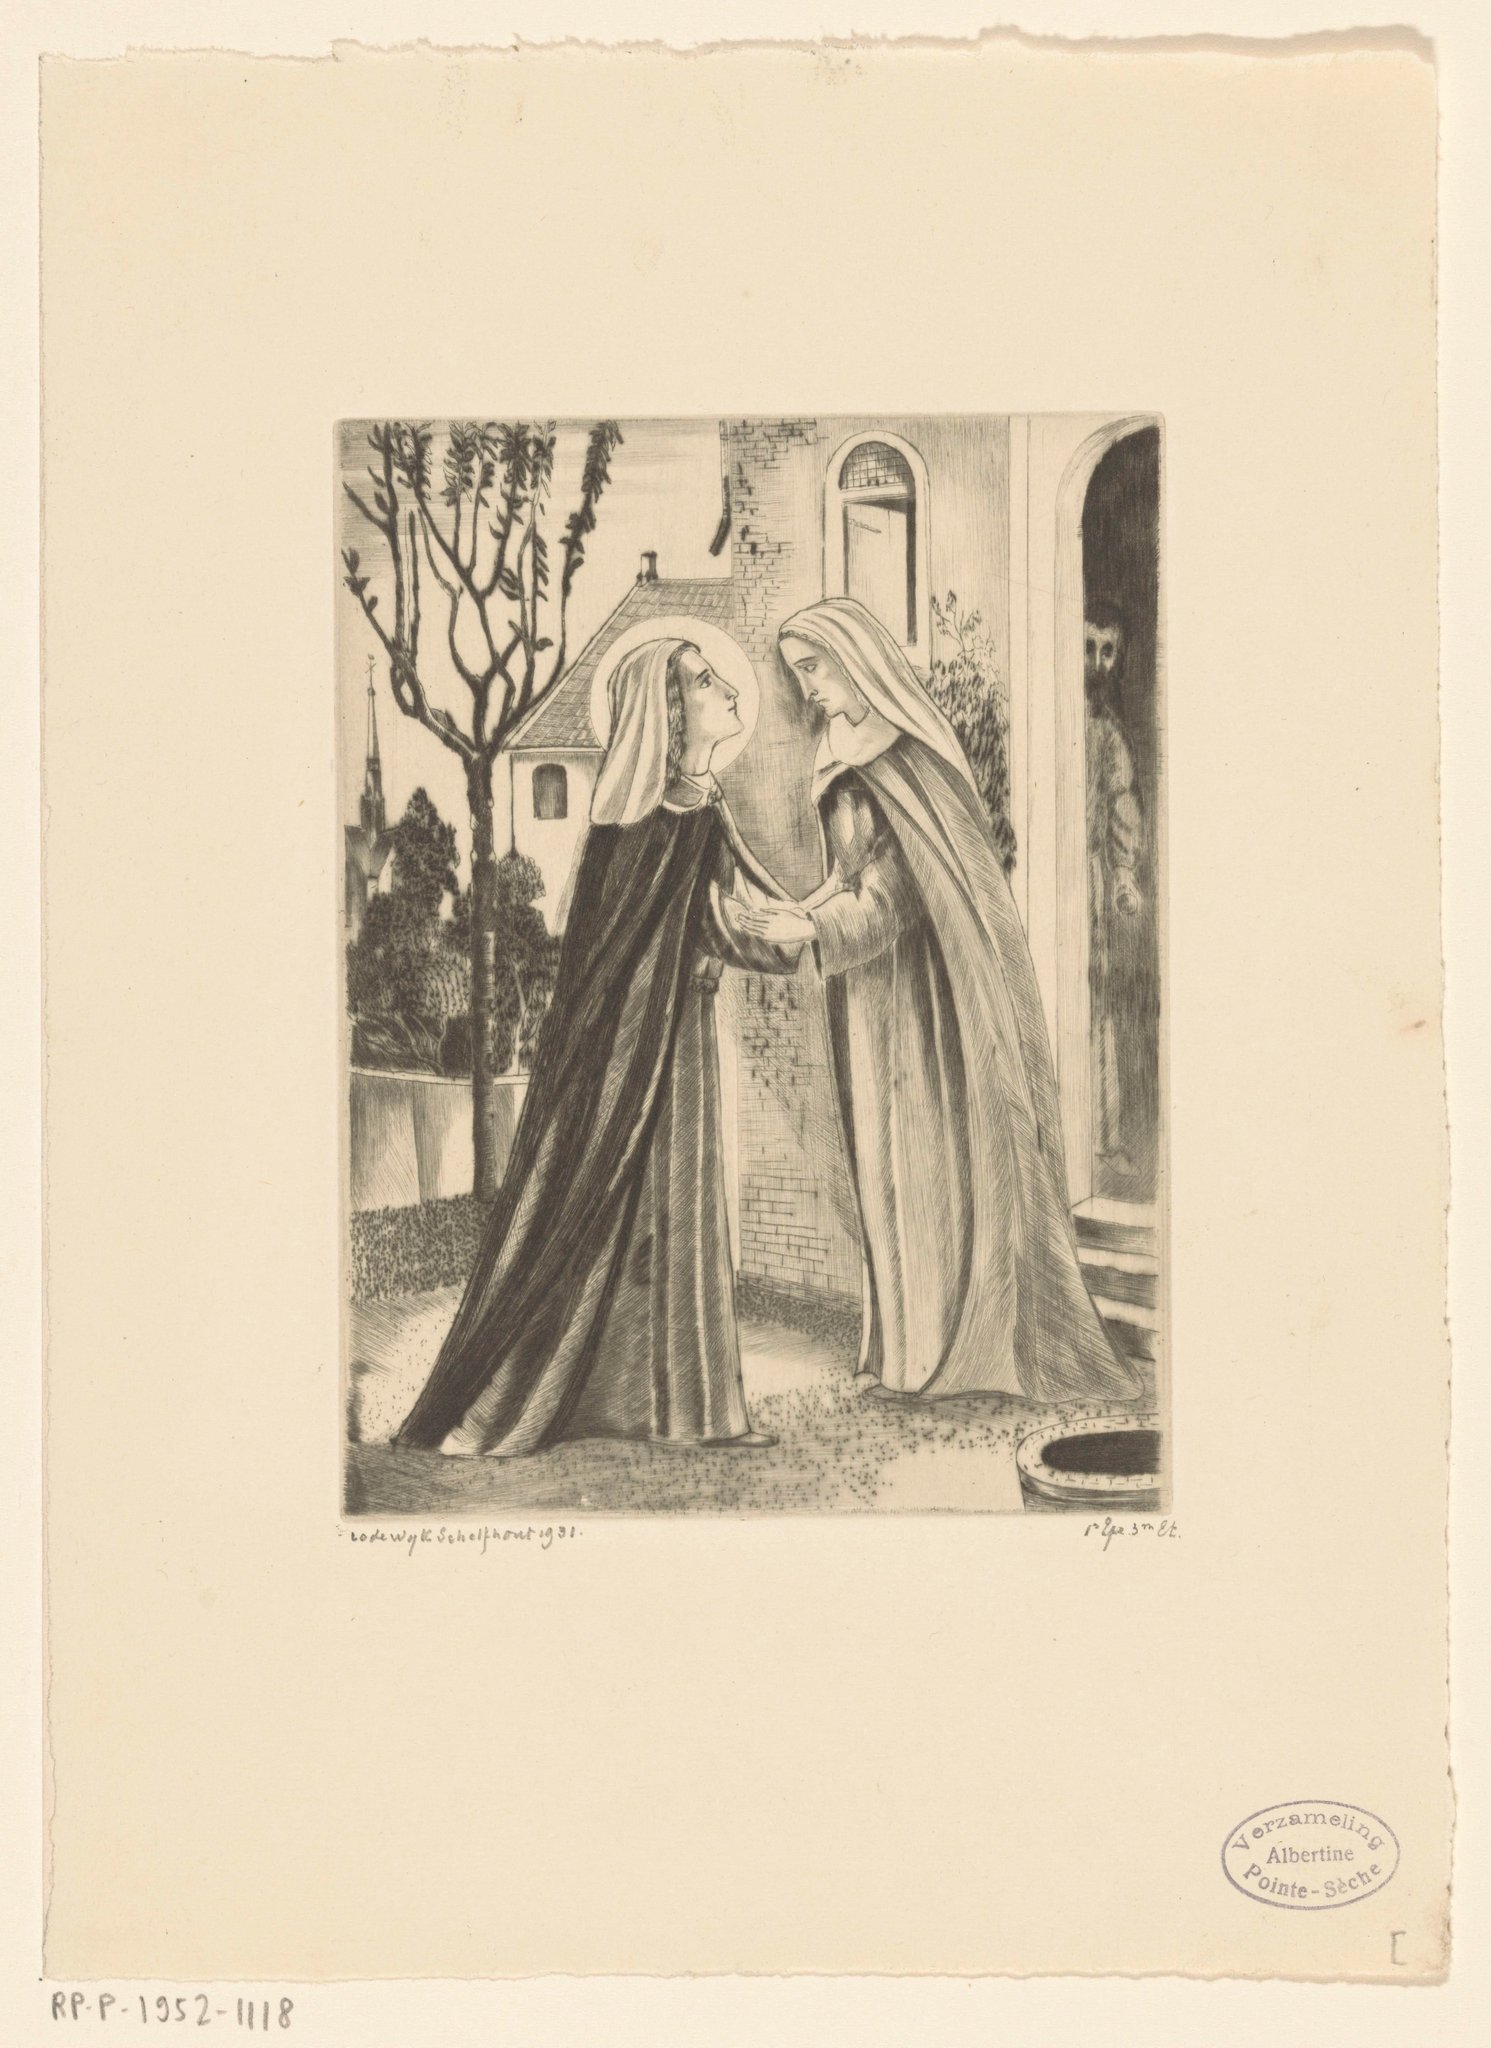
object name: print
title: Visitatie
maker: lodewijk schelfhout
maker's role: draughtsman, print maker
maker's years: 1881-1943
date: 1931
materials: paper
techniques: drypoint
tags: visitation (possibly joseph and/or zacharias present) (luke 1:39-56)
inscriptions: collector's mark: Lugt 5i, collector's mark: Lugt 2228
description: Maria wordt begroet daar haar nicht Elisabet voor het huis van Zacharias, de echtgenoot van Elisabeth. Zacharias bevindt zich in de deuropening van het huis. Op de achtergrond planten en gebouwen, waaronder een kerk.